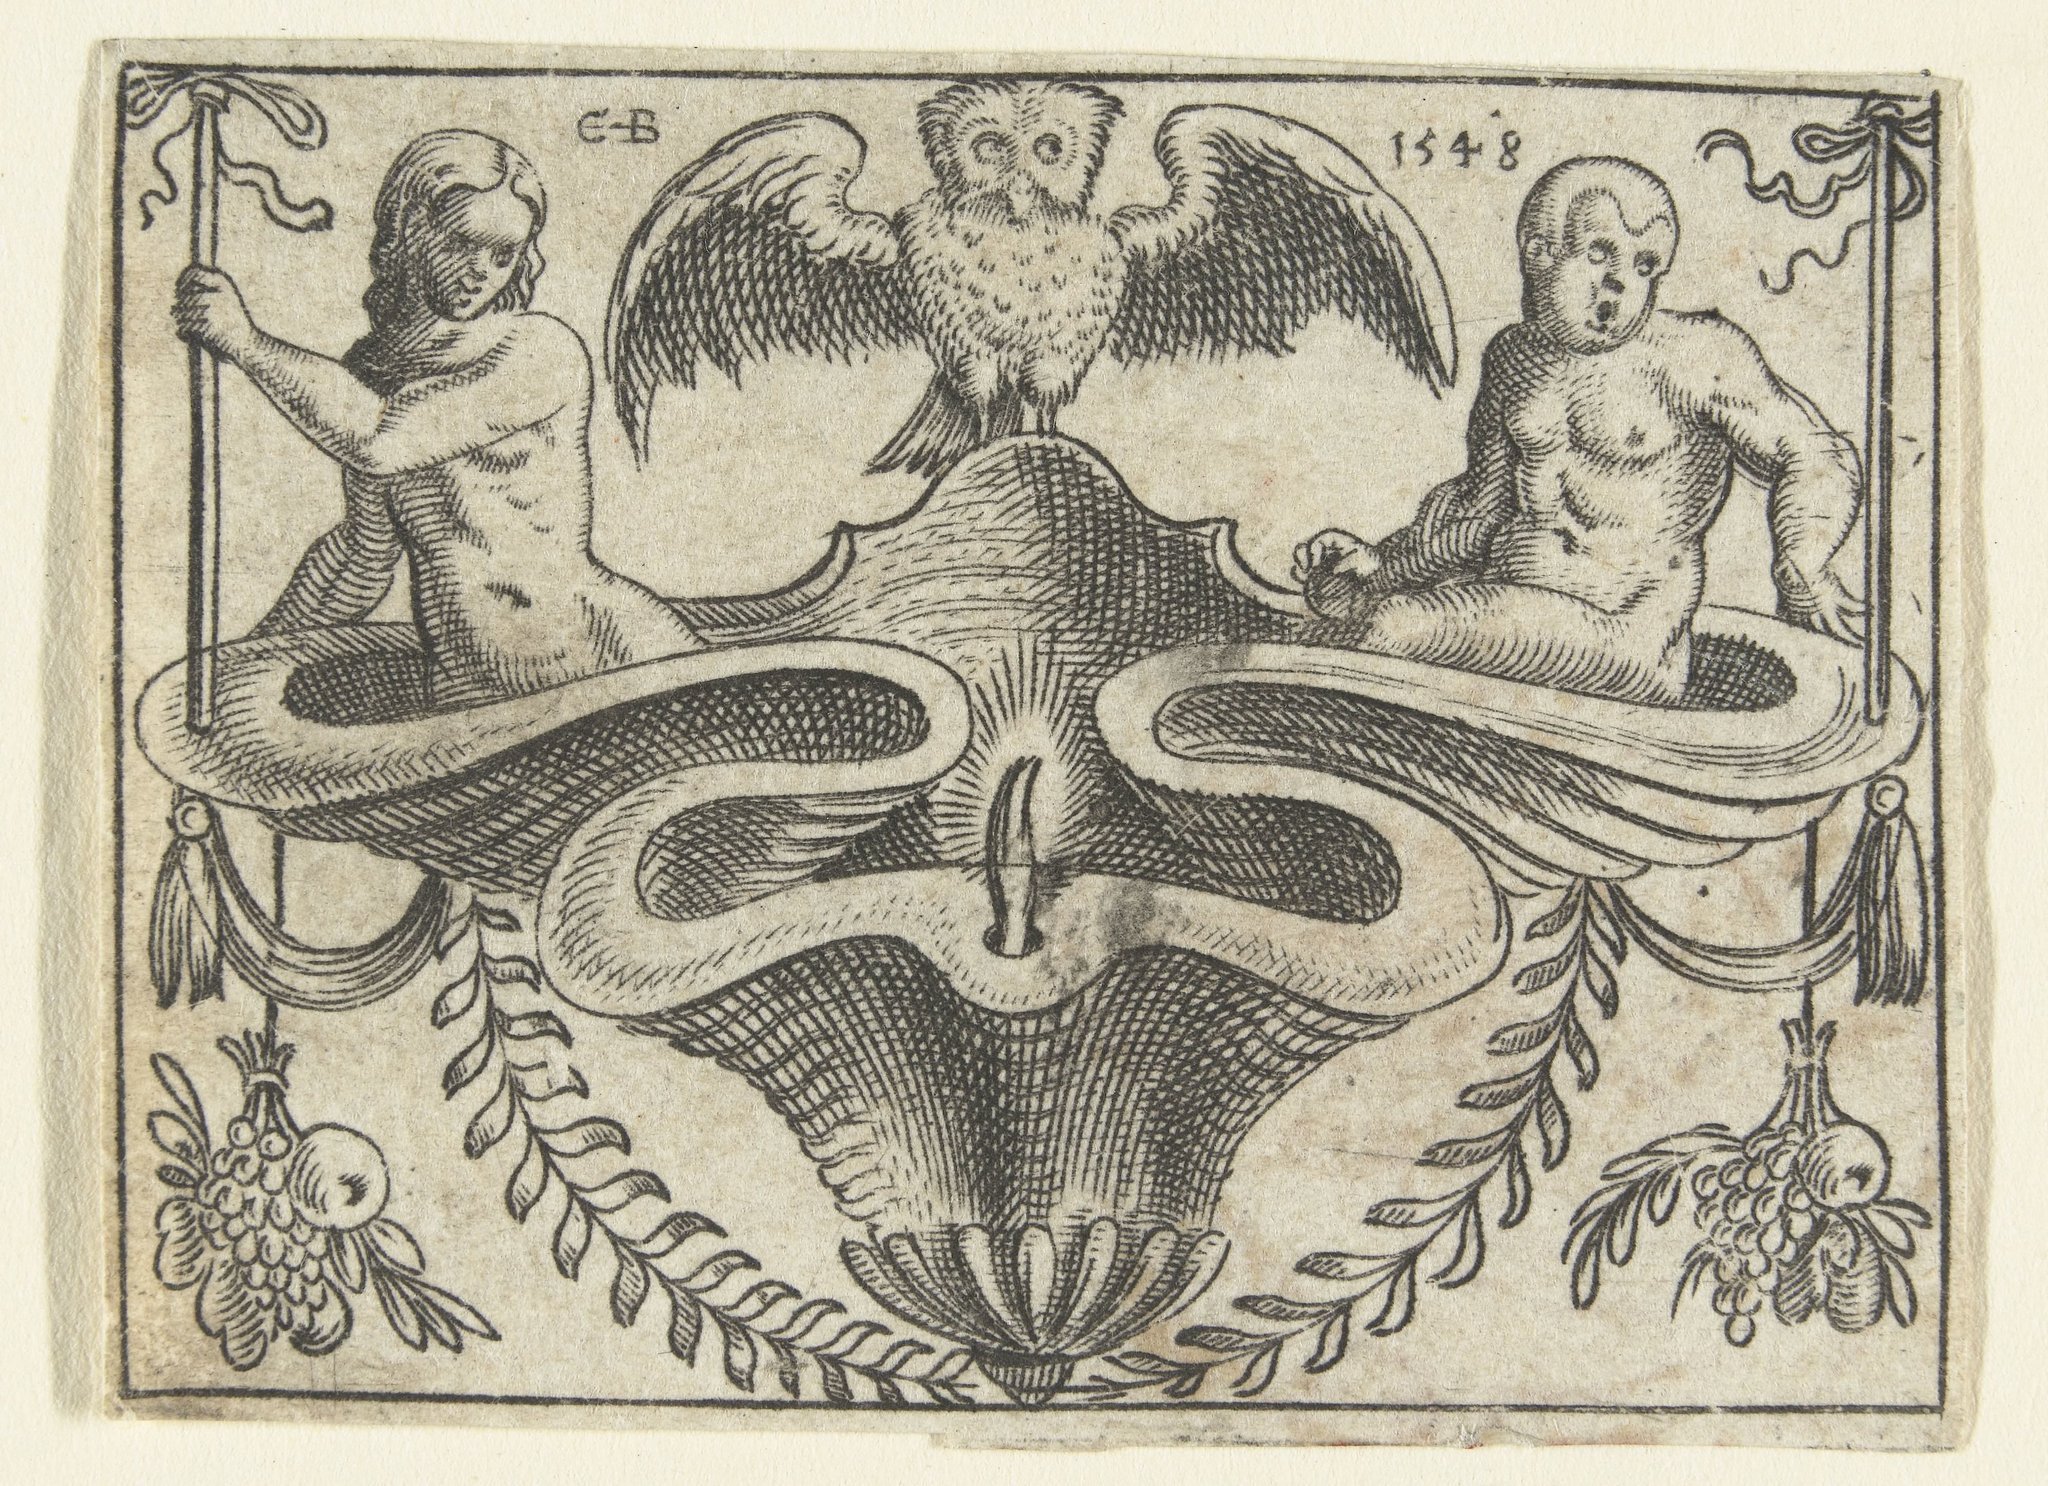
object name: print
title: Kleine vlakdecoraties met grotesken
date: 1548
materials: paper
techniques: engraving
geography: netherlands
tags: fantasy ornament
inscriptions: date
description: In het bekken zitten een man en een vrouw. Midden achter zit een uil, midden voor brandt een vlammetje. Een van 4 bladen uit een serie van 8.